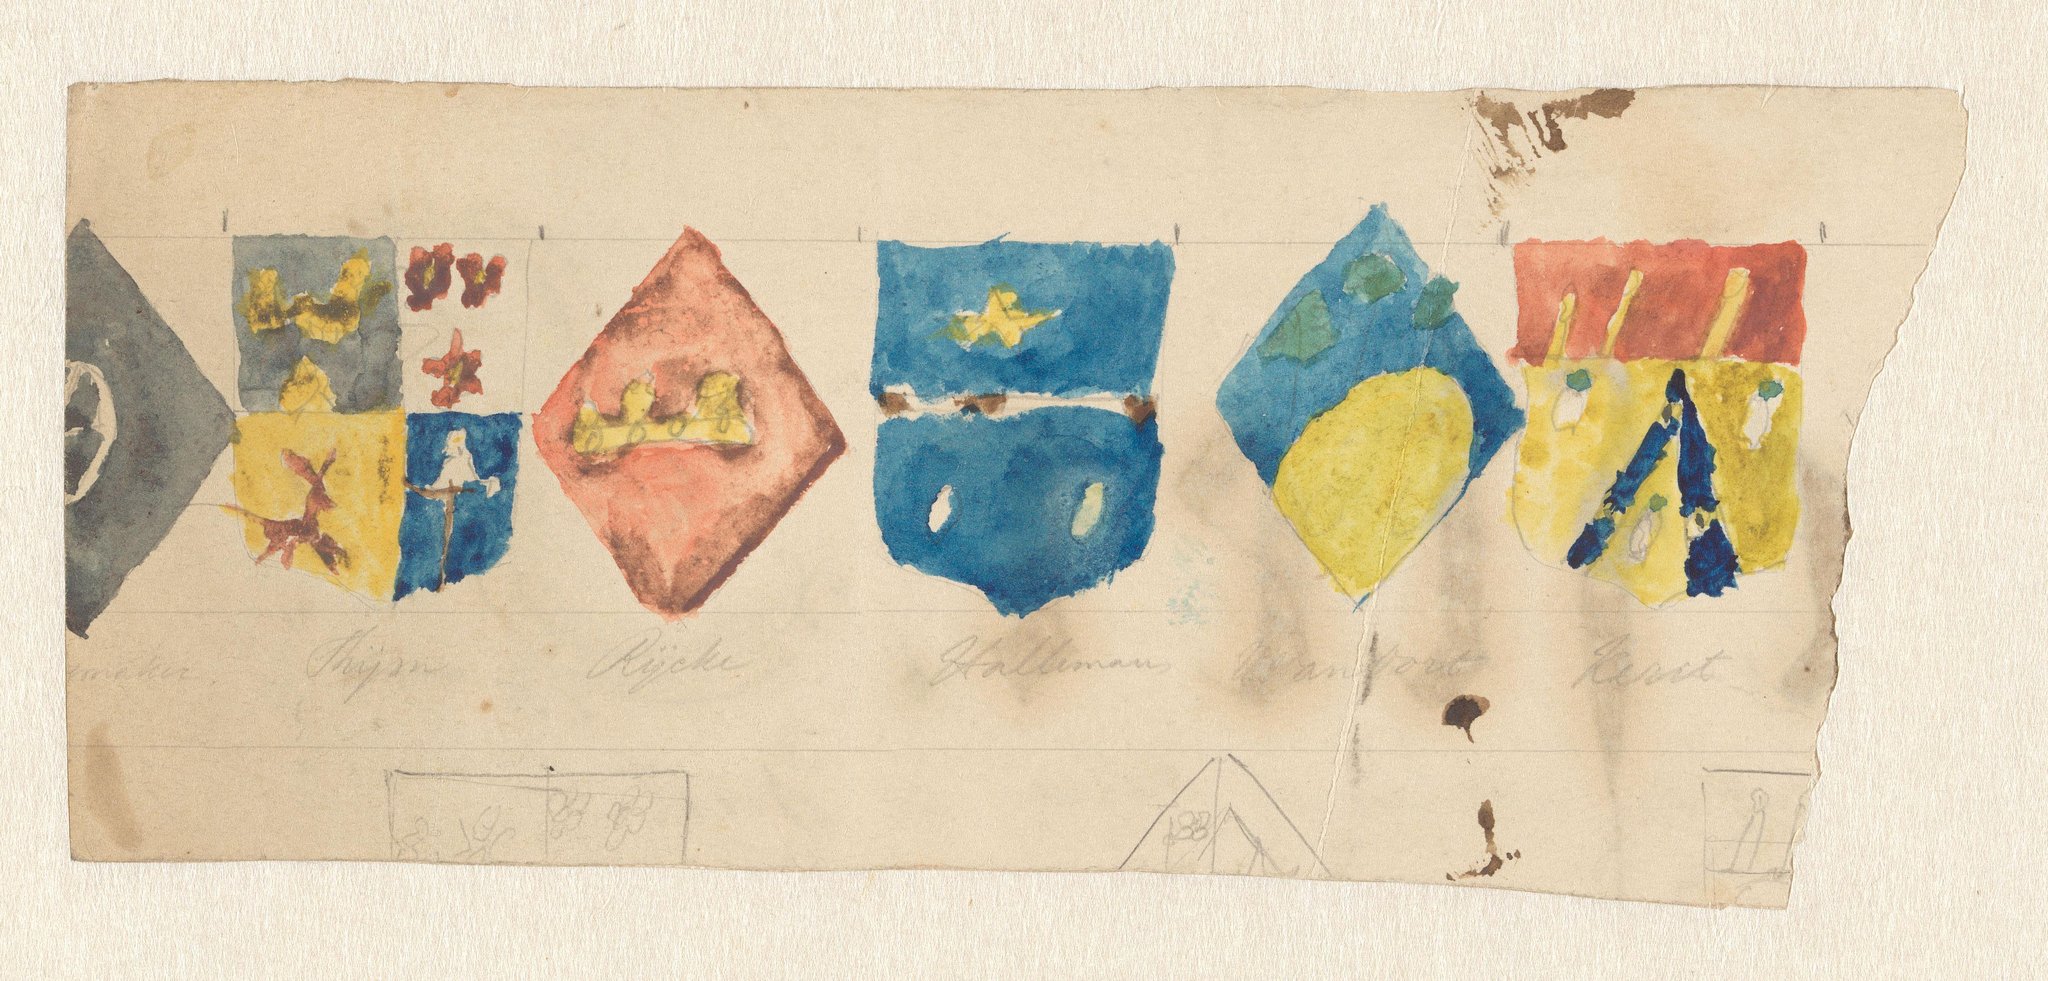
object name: drawing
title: Wapenschilden van onder meer de families Thijm, Kerst en Rijcke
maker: joannes carolus alberdingk thijm (jan)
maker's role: pater, schrijver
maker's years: 1847-1926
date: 1858-1865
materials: ink, paper, pencil, watercolor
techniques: brush, pen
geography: netherlands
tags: armorial bearing, heraldry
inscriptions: inscription: ‘[...]maker / Thijm / Rijcke / Halleman / Van Hout / Kerst’